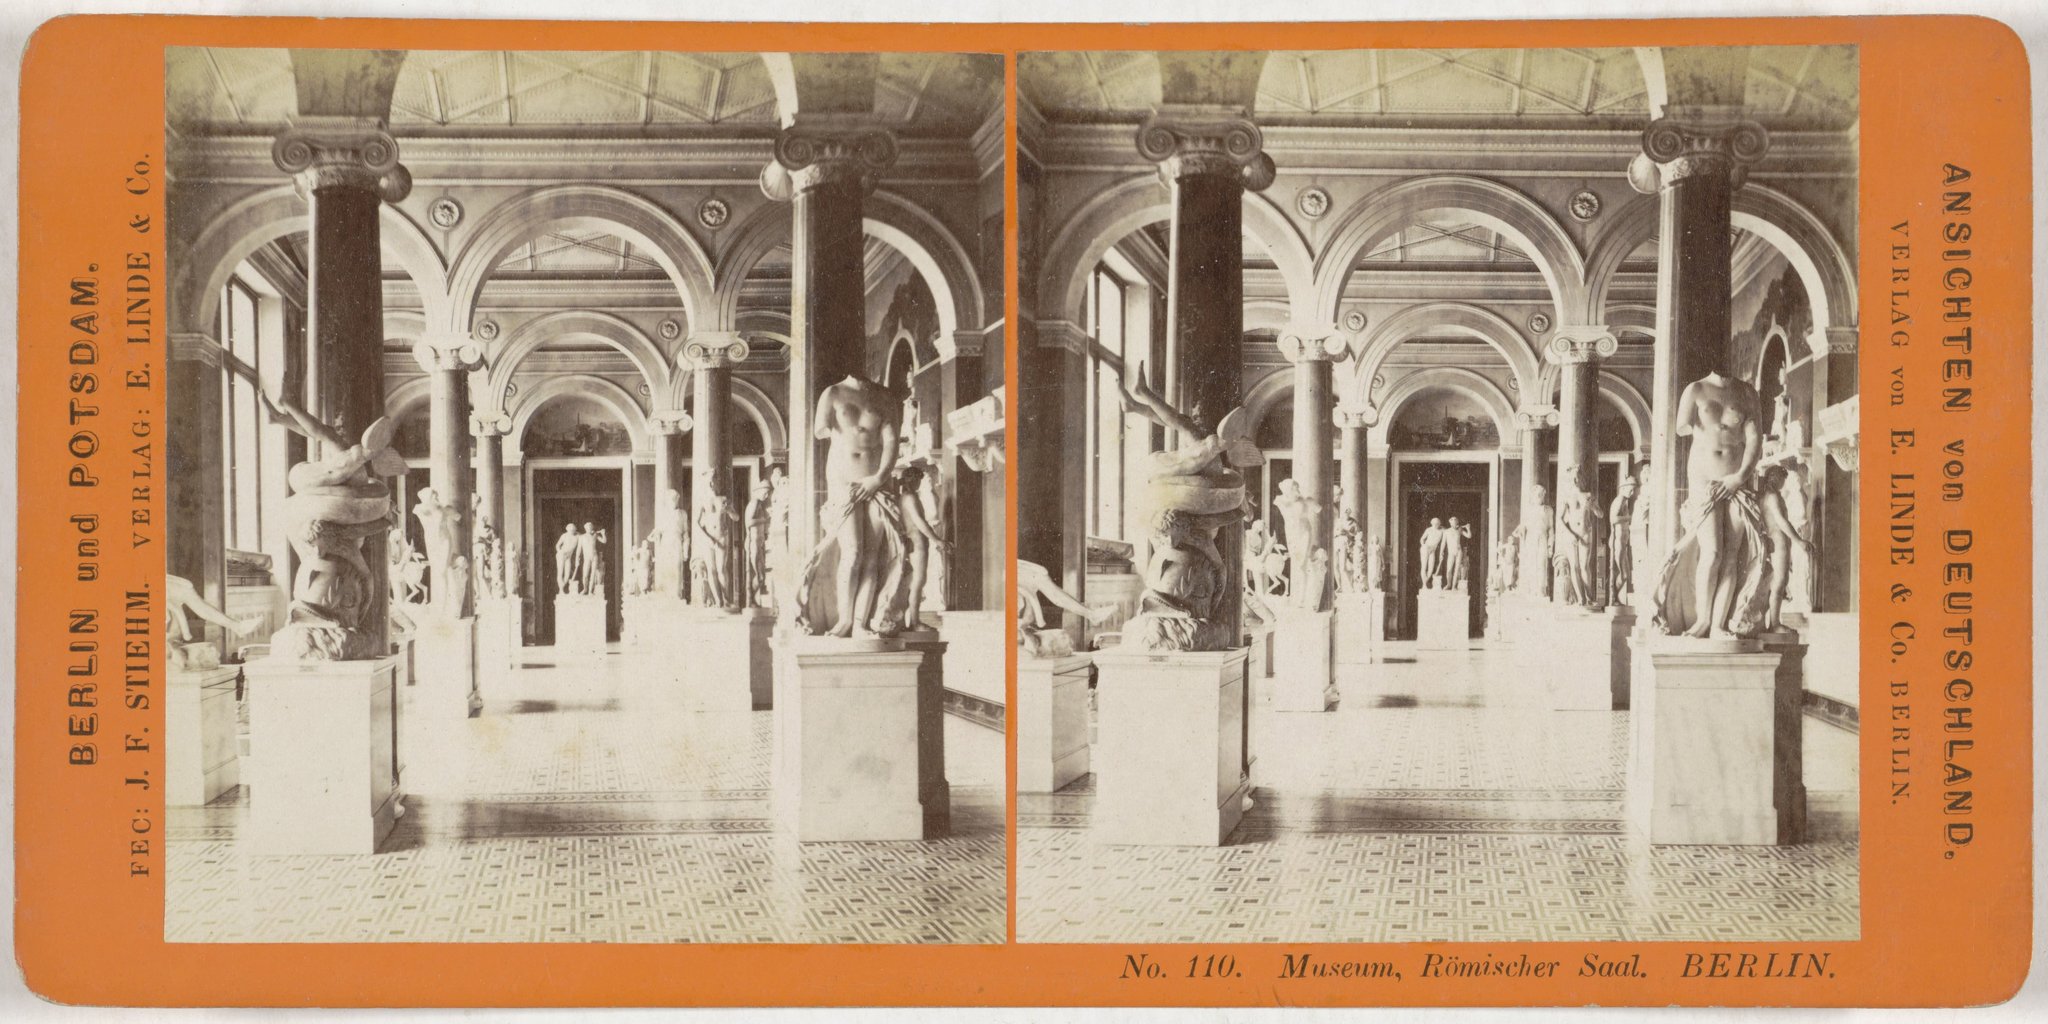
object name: stereograph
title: Museum, Römischer Saal. Berlin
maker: johann friedrich stiehm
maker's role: fotograaf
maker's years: 1826-1902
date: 1868-1870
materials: cardboard, paper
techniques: albumen print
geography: berlin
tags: permanent exhibition, museum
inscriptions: number: ‘No. 110’